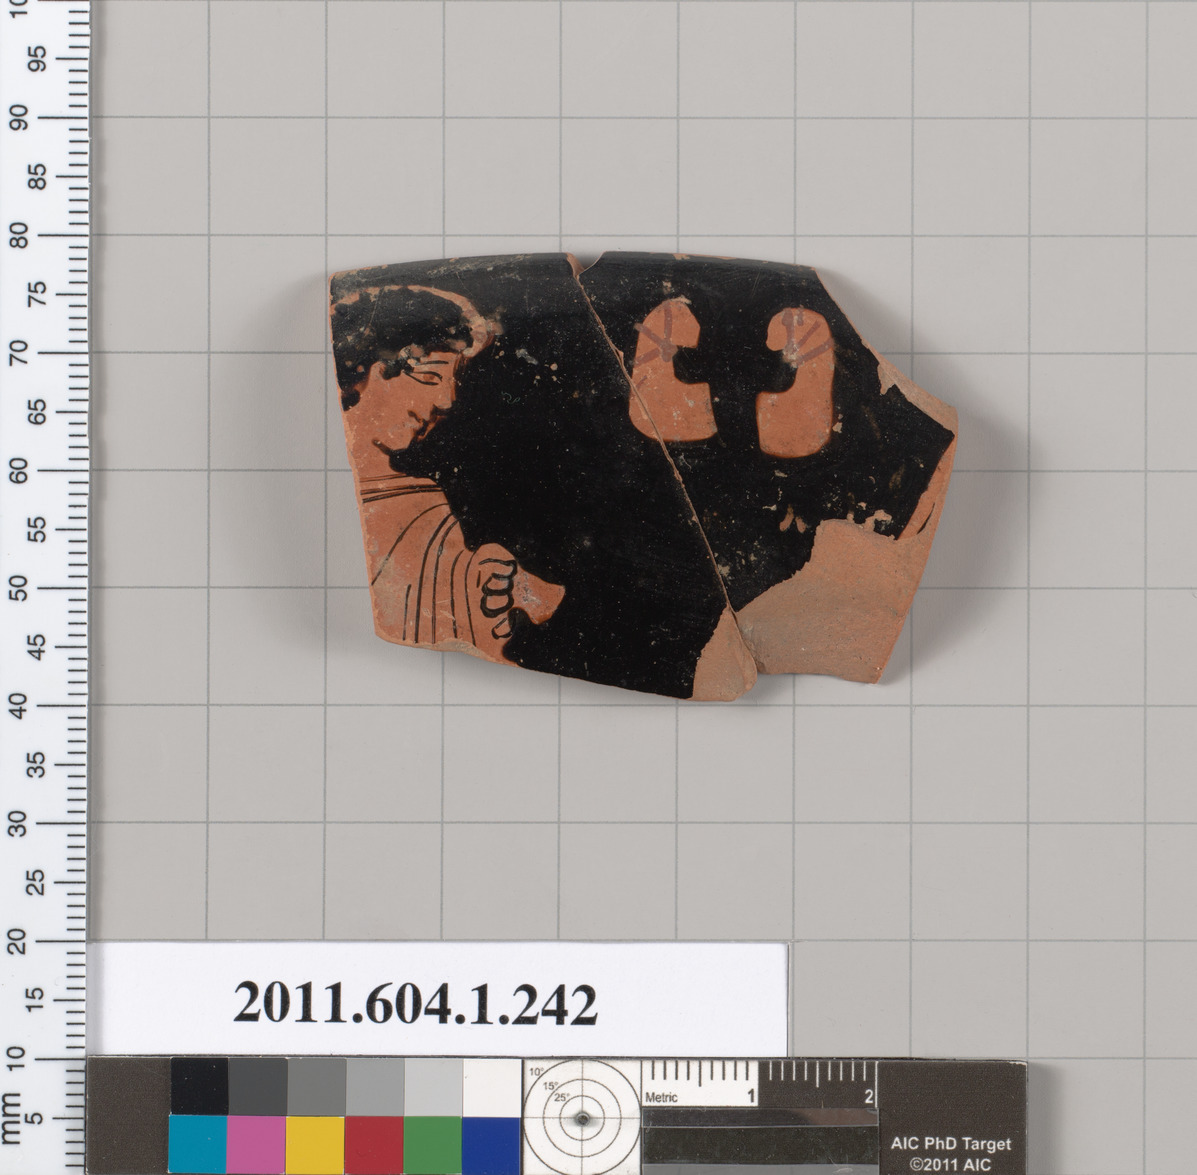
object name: kylix fragment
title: Terracotta rim fragment of a kylix (drinking cup)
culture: greek, attic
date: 475-451 BCE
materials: terracotta